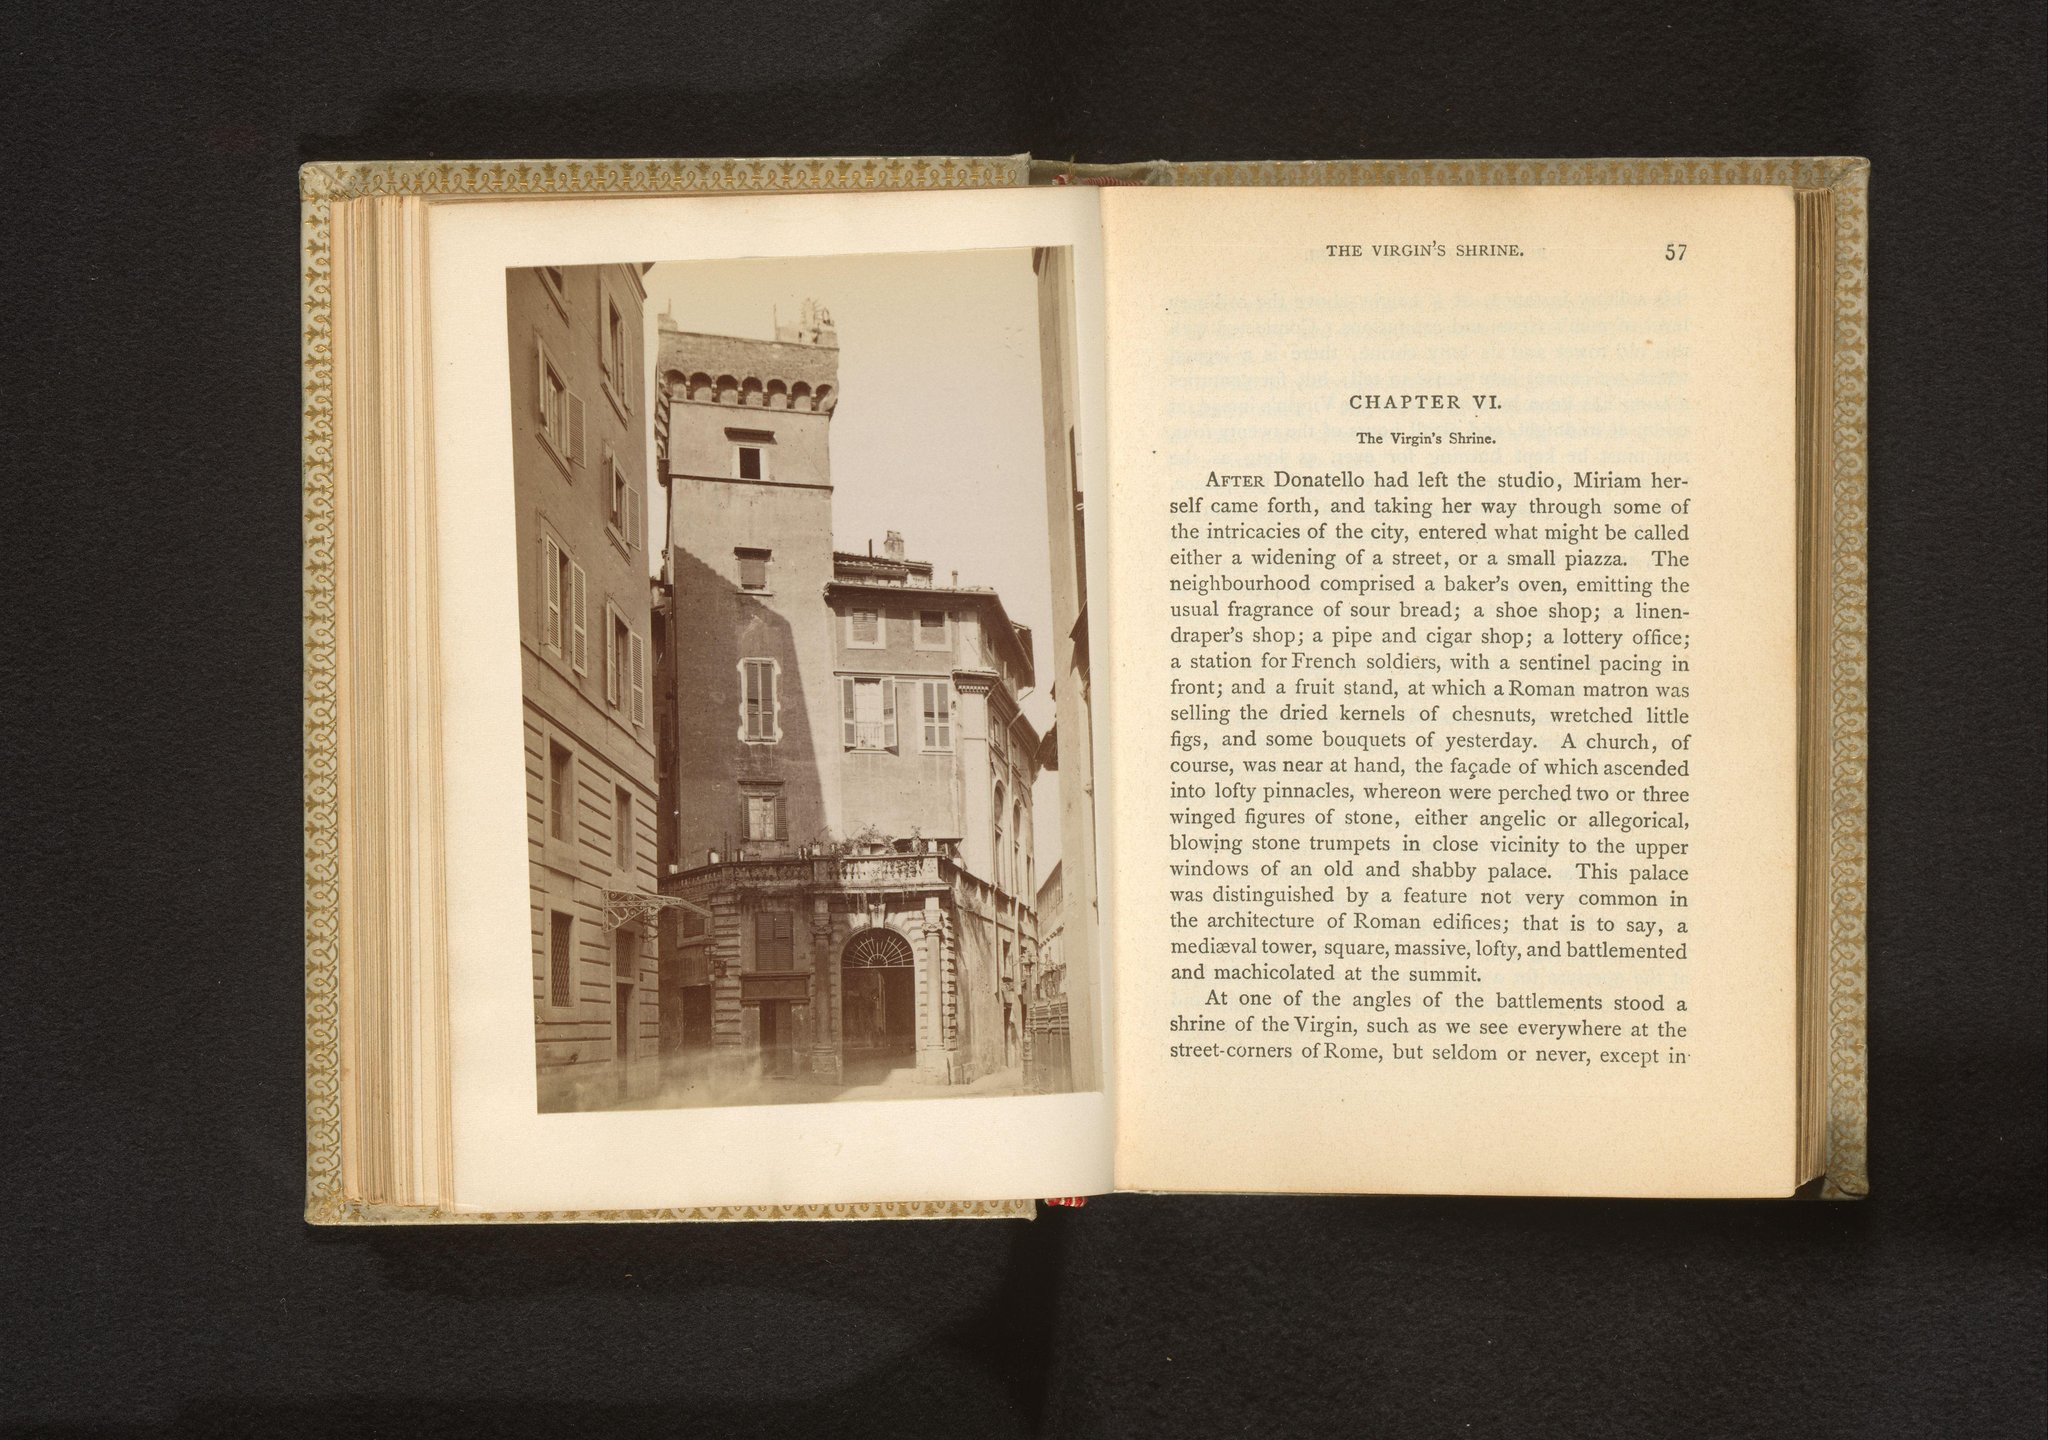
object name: photograph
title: Gezicht op Palazzo Scapucci in Rome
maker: Anonymous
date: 1850-1860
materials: photographic support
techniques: albumen print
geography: rome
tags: hôtel, i.e. small palace in city, rome